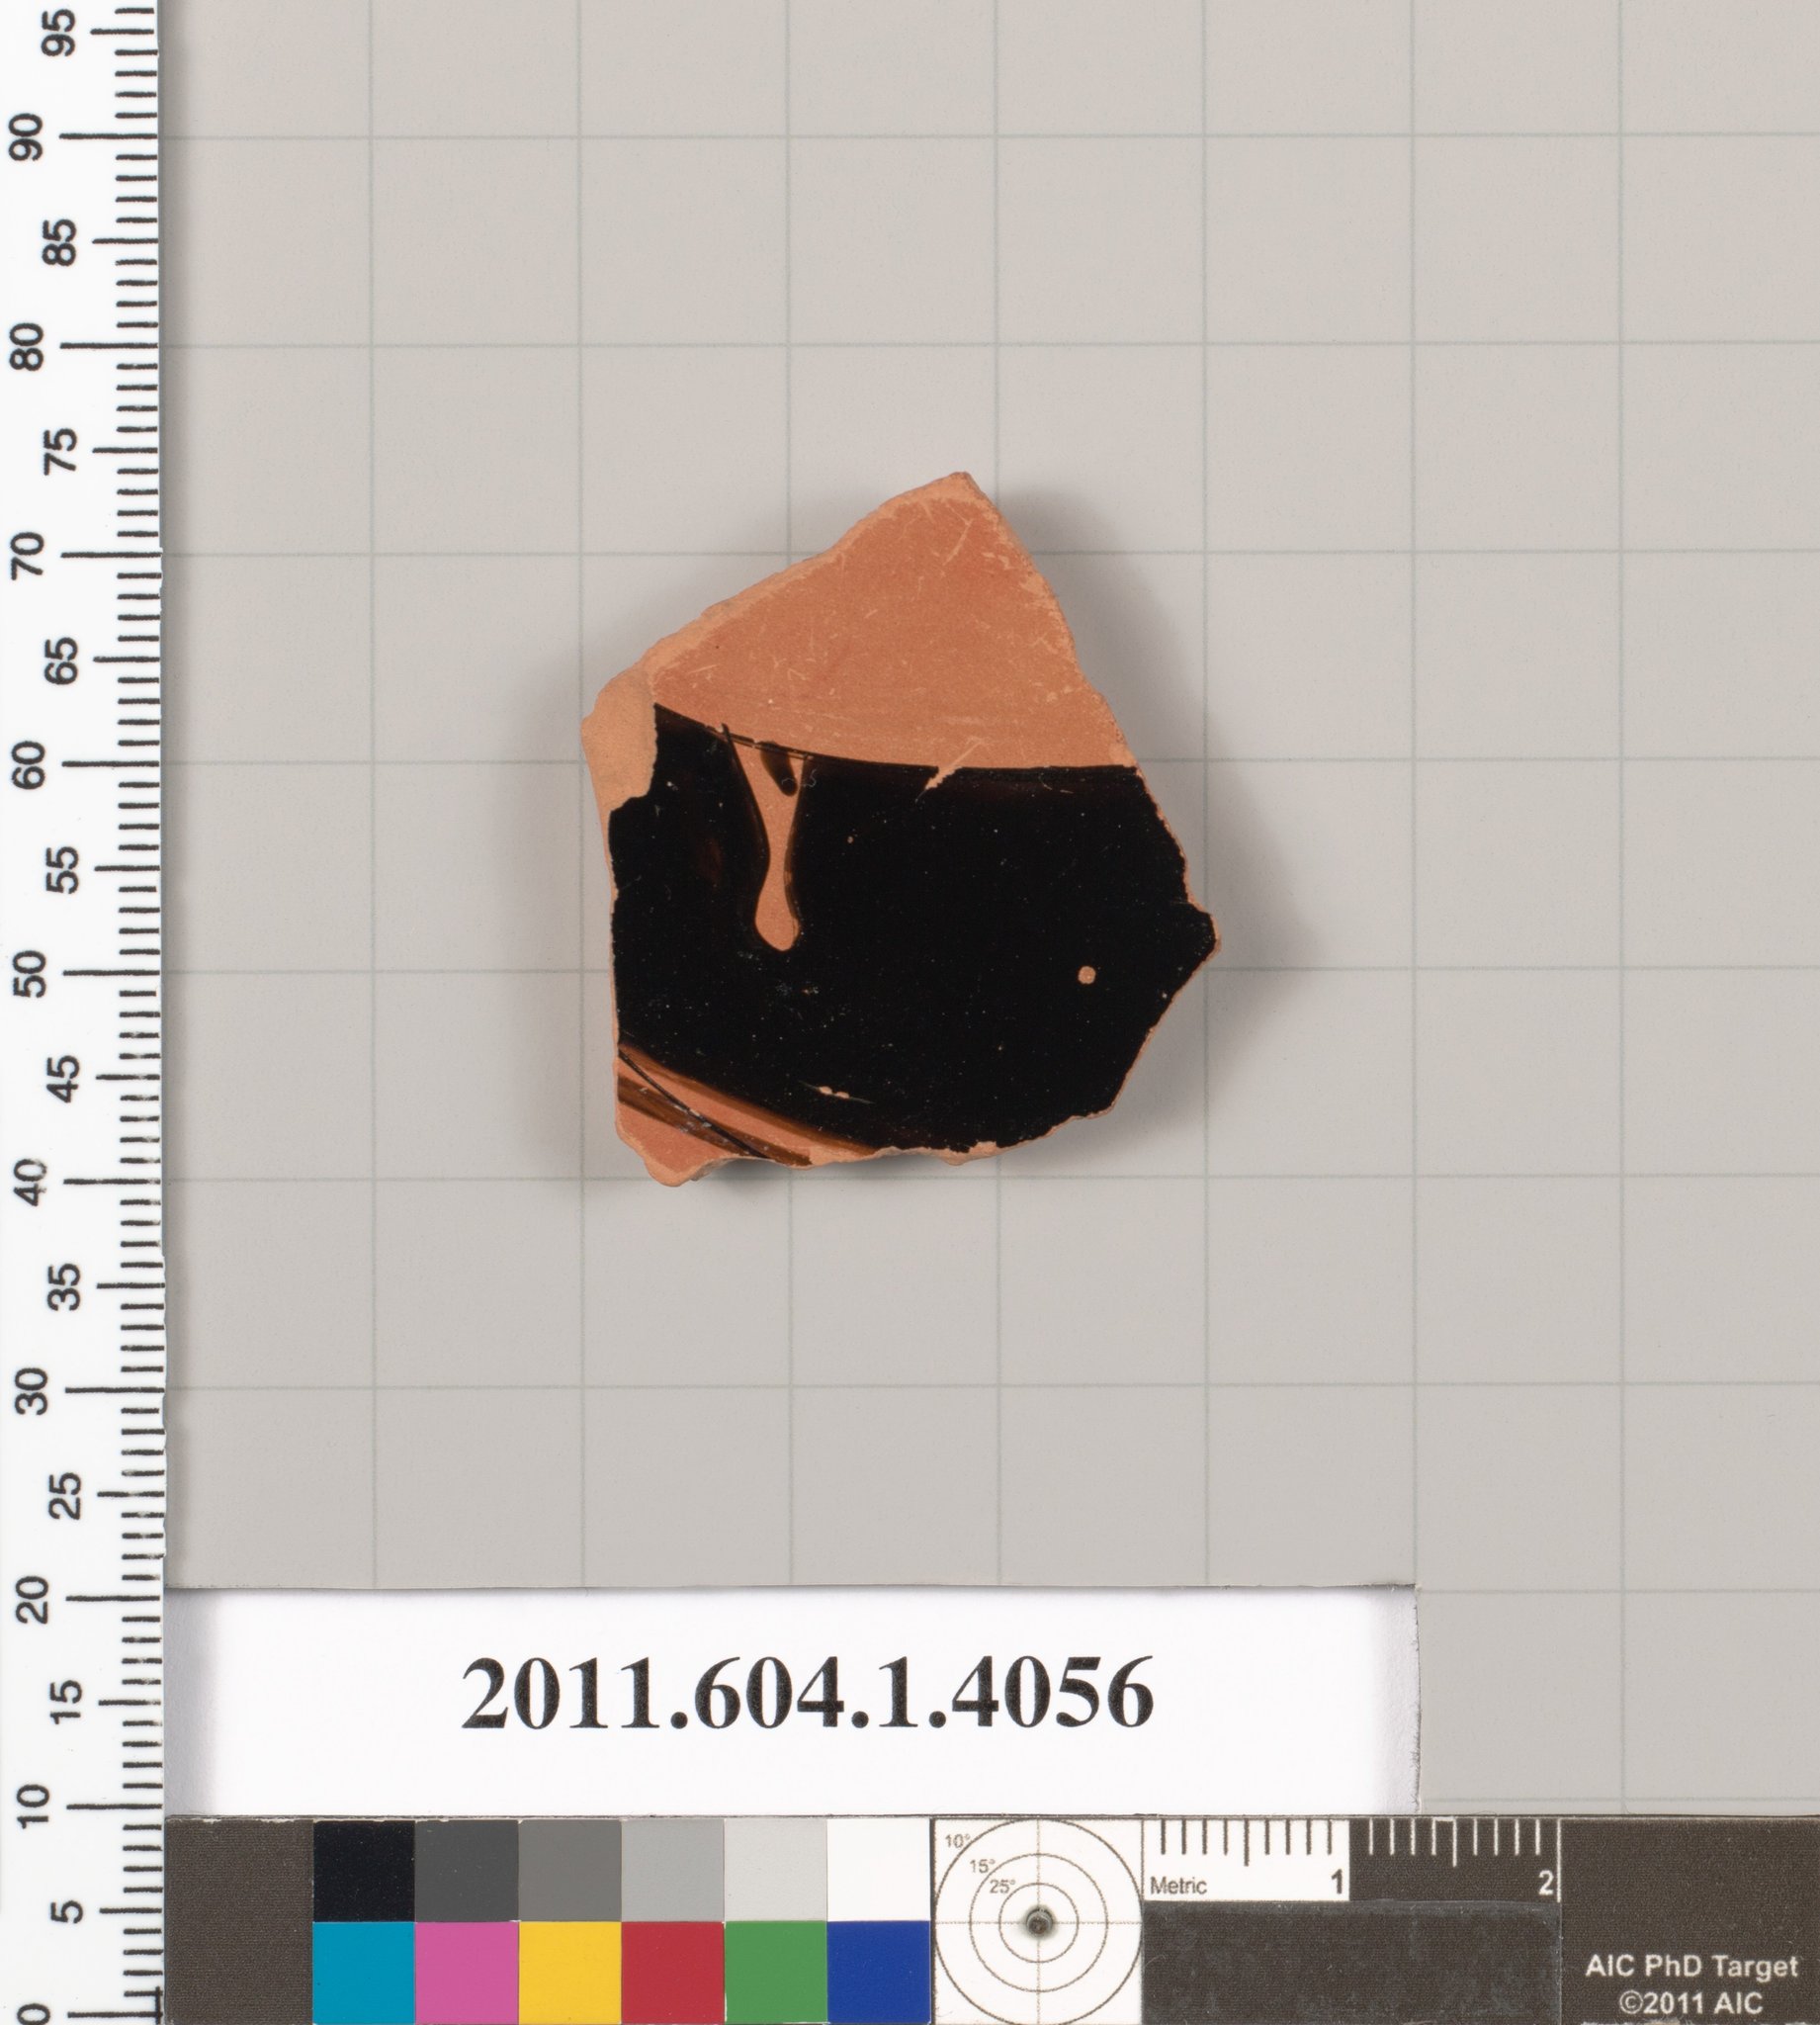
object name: kylix fragment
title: Terracotta fragment of a kylix (drinking cup)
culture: greek, attic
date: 500-451 BCE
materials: terracotta